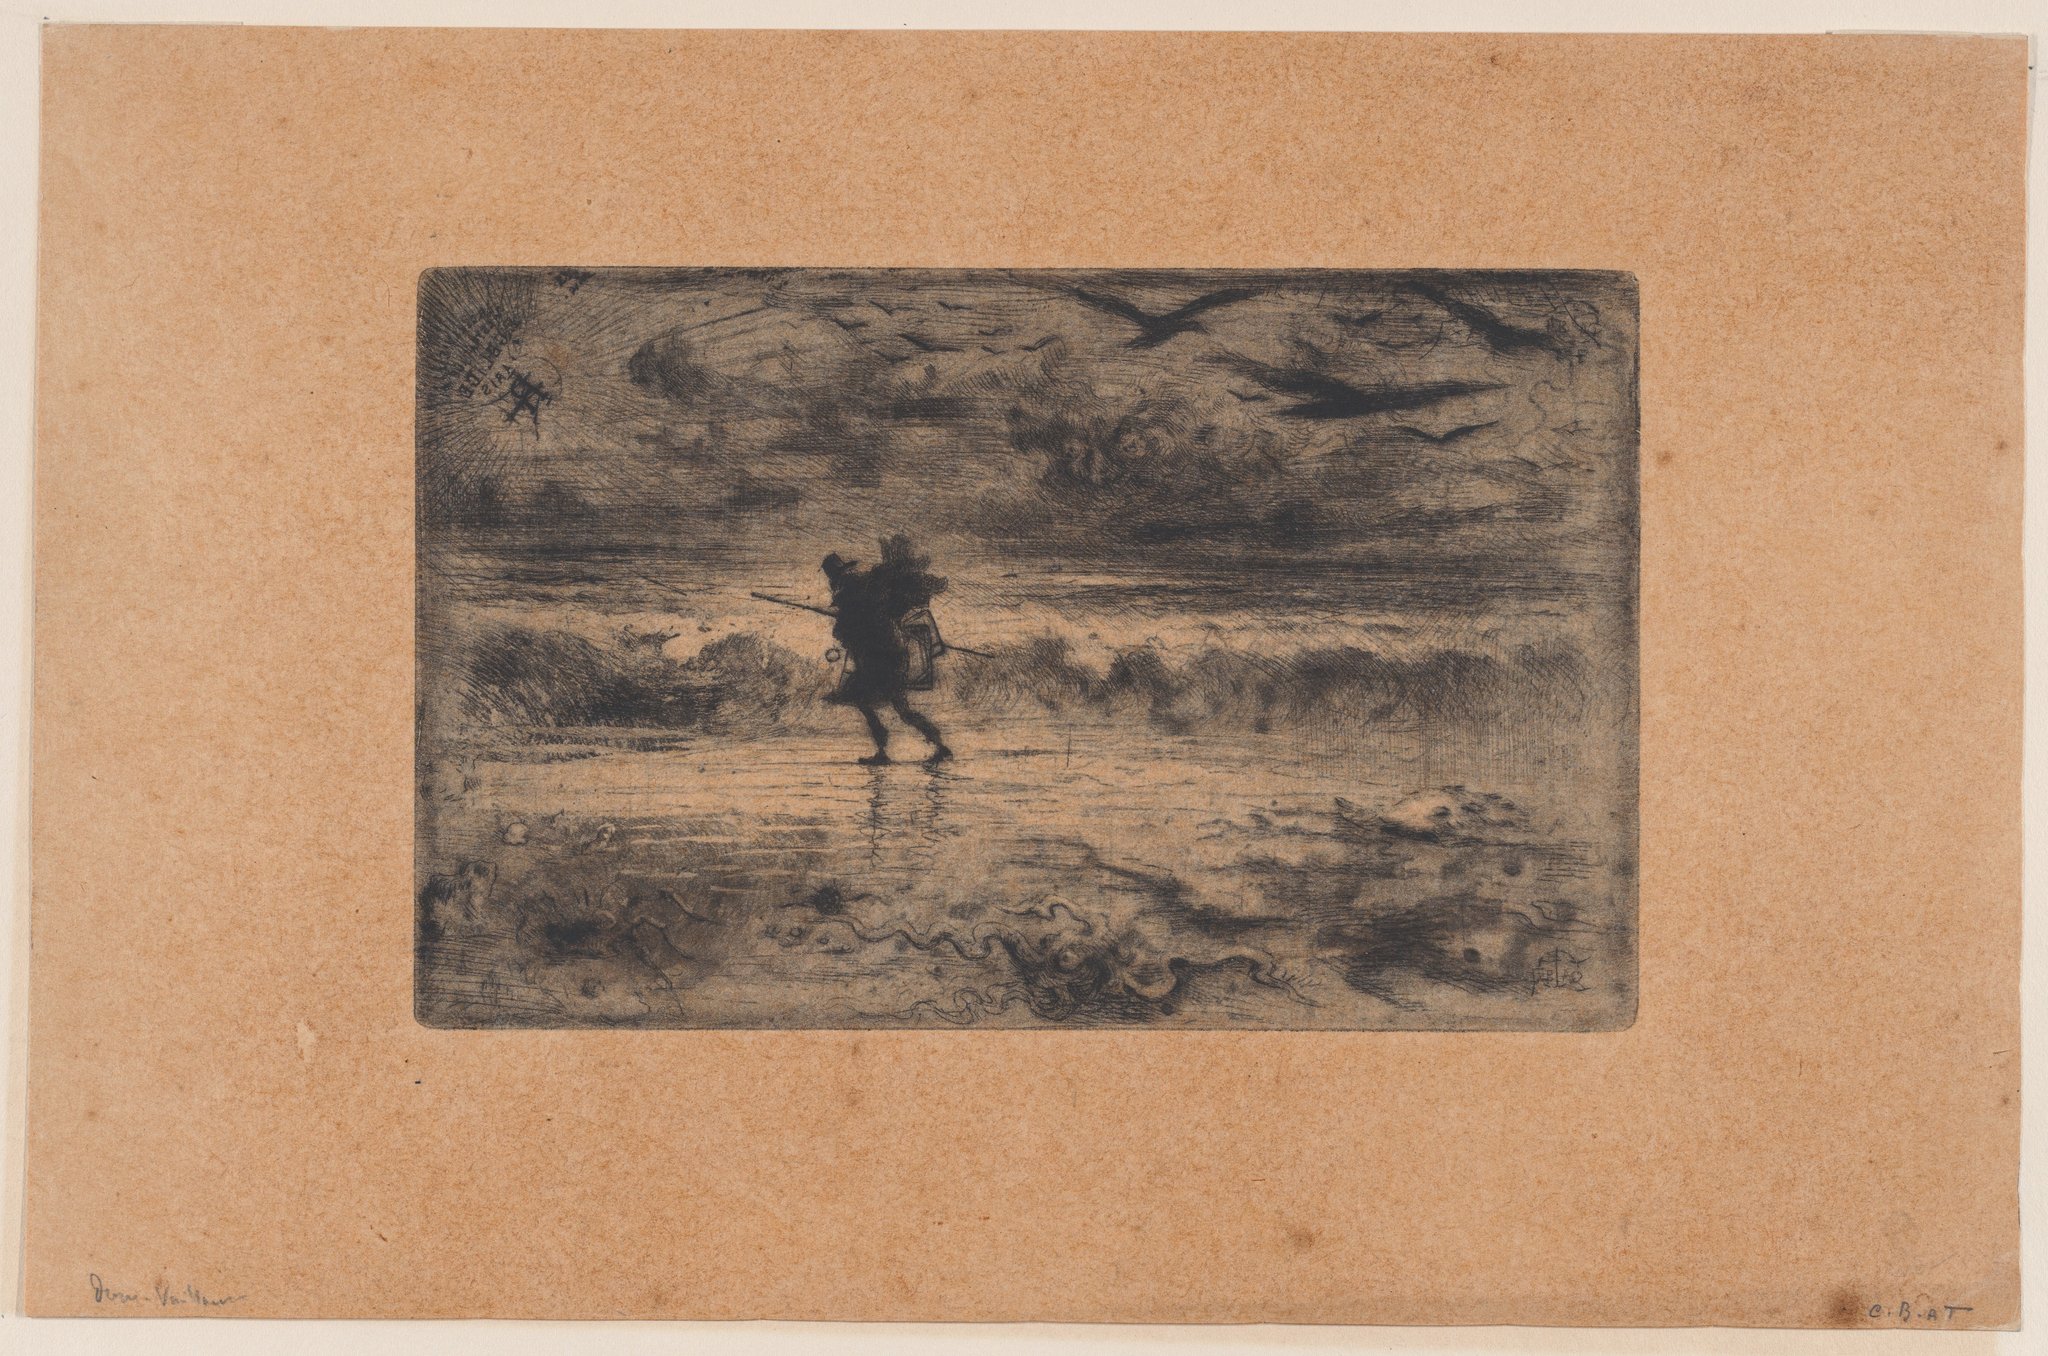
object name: print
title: The Seascape Painter (Le Peintre de marine)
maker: félix-hilaire buhot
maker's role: artist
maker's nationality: french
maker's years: 1847-1898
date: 1860-1898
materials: paper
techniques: aquatint, drypoint, etching